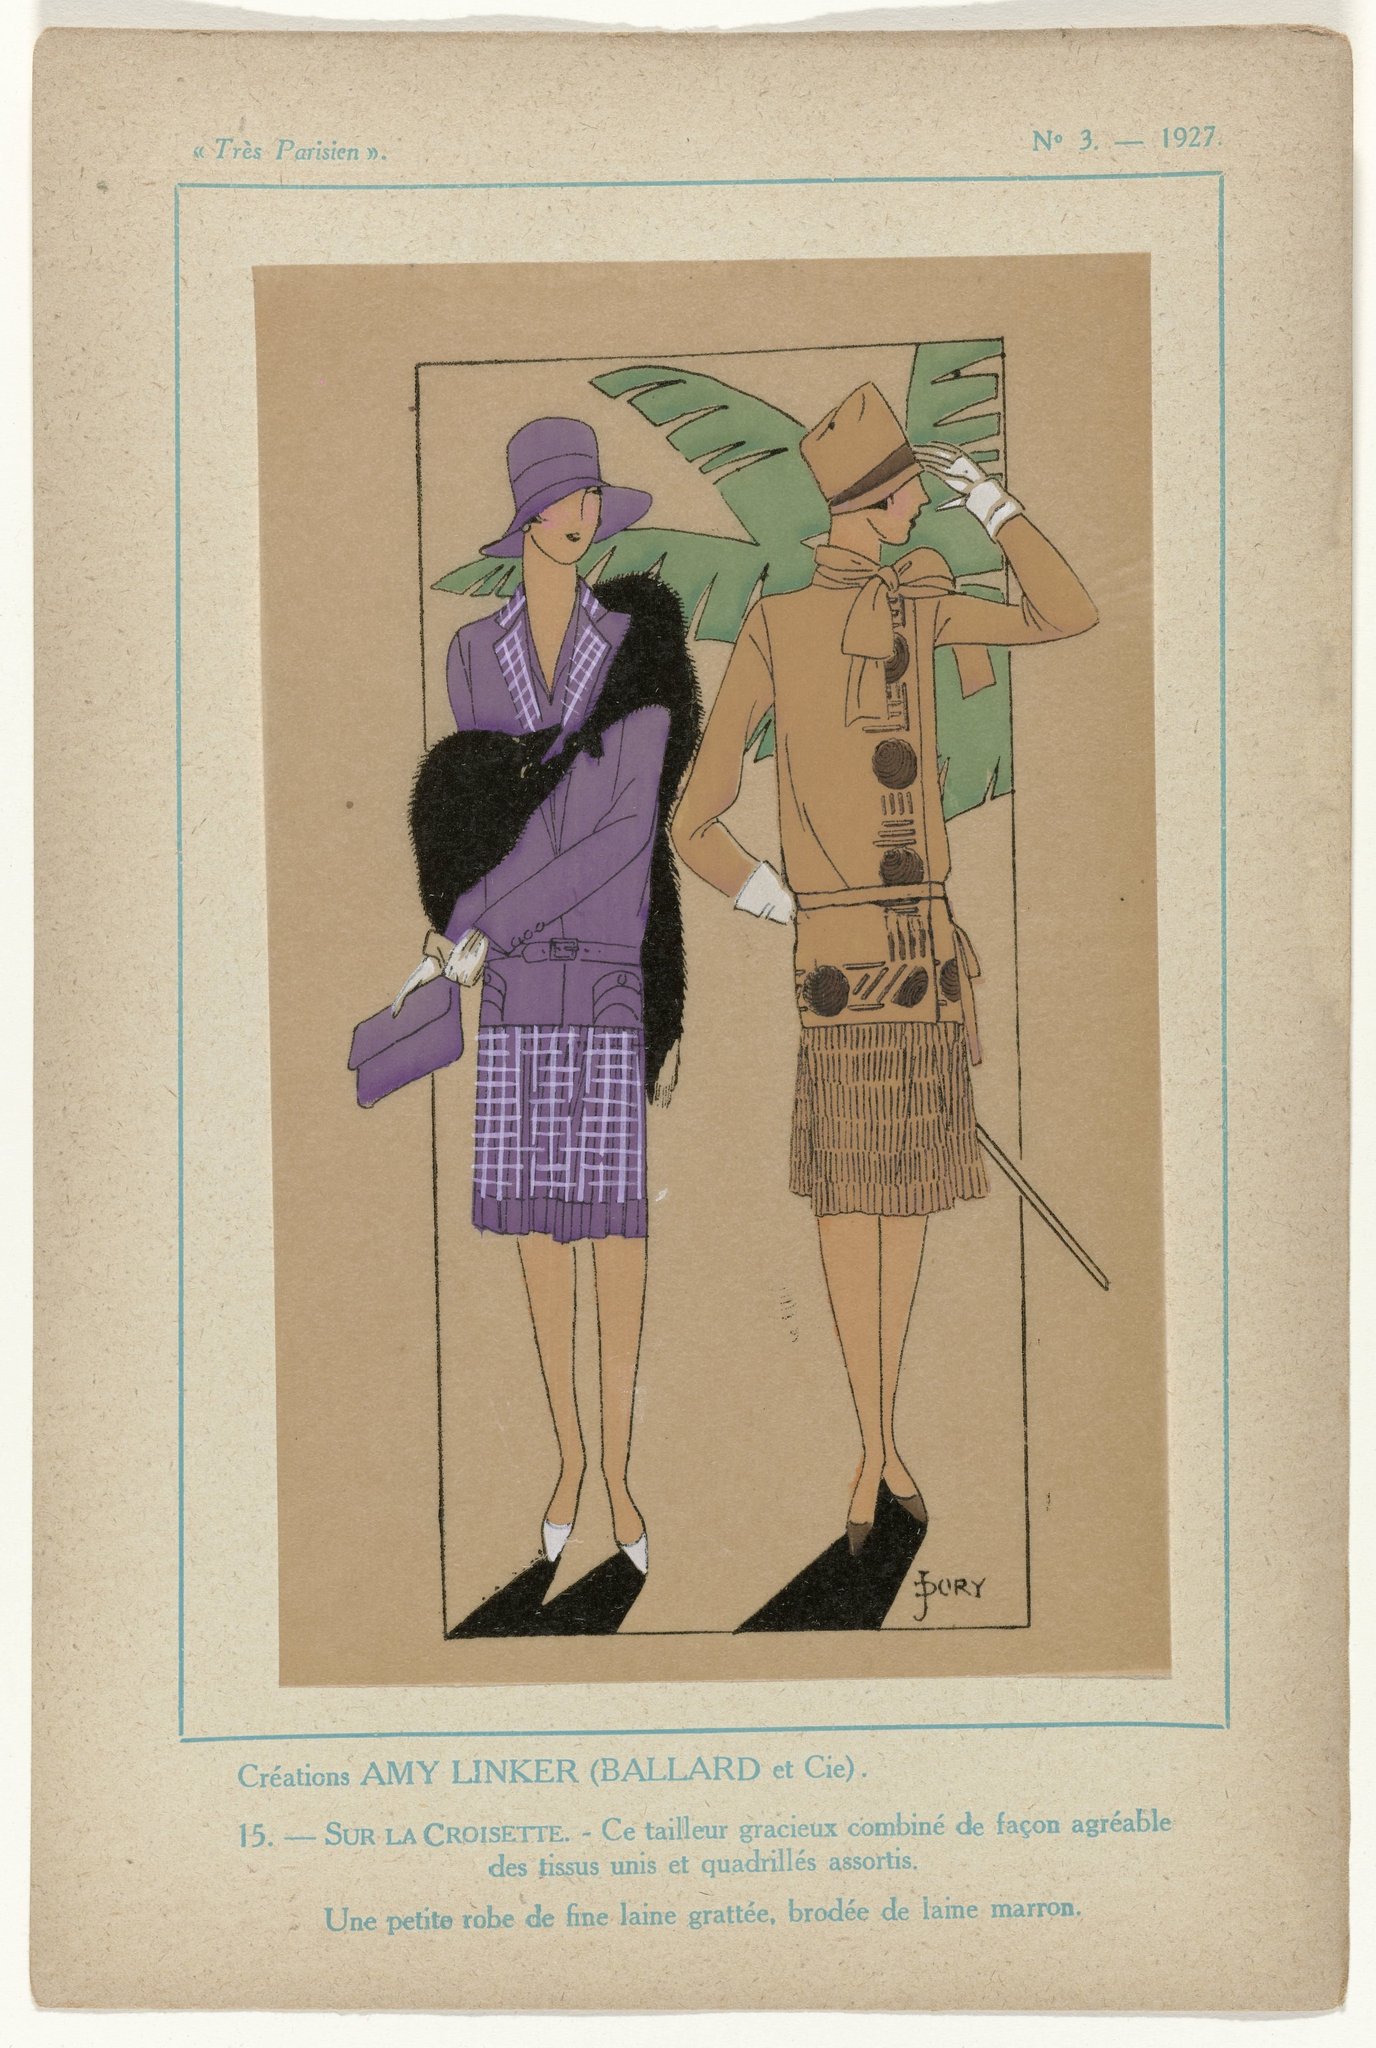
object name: fashion print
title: Très Parisien, 1927, No. 3, Pl. 15: Créations AMY LINKER (BALLARD et Cie) - SUR LA CROISETTE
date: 1927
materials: paper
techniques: hand coloring, letterpress printing, lithography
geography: paris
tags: dress, gown: day dress (+ women's clothes), bag (clutch) (+ women's clothes), ensembles of pieces of clothing (tailleur) (+ women's clothes), walking-stick, staff, fashion plates, head-gear: hat (+ women's clothes)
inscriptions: caption: ‘SUR LA CROISETTE. - Ce tailleur gracieux combiné de façon agréable des tissus unis et quadrillés assortis. Une petite robe de fine laine grattée, brodée de laine marron.’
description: Tailleur en 'petite robe' van Amy Linker (Ballard et Cie) . Prent uit het modetijdschrift Très Parisien...La Mode, Le Chic, L'Élégance (1920-1936)